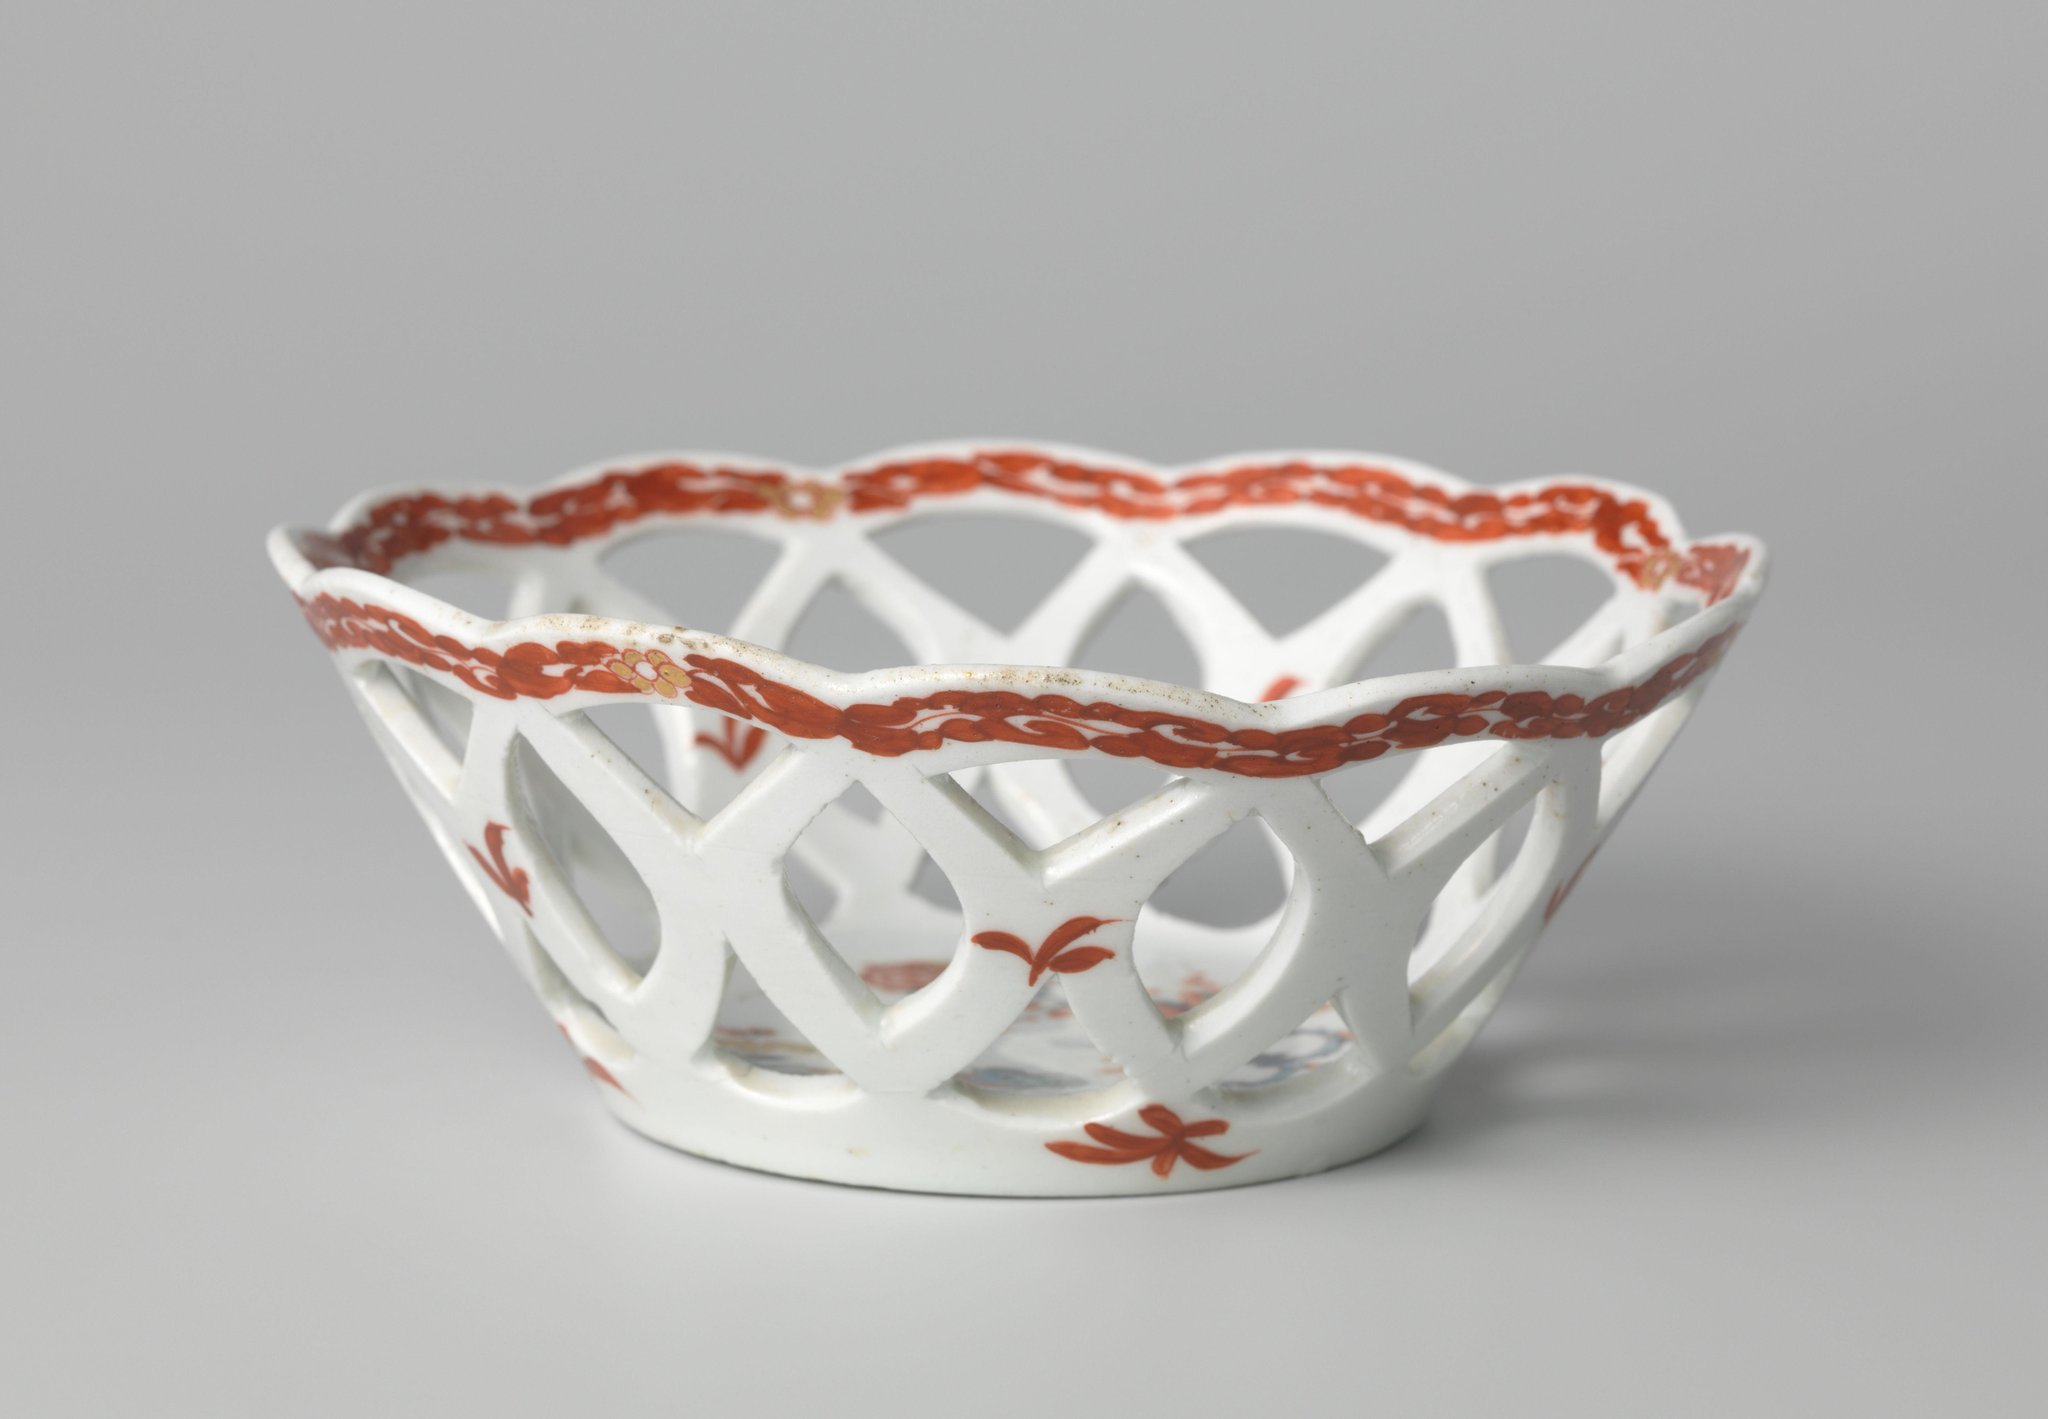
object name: bowl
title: Bowl with quails near flowering plants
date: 1750-1774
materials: glaze, gold, paint, porcelain, soft paste porcelain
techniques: embroidery, firing, forming, gilding, turning, vitrification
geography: worcester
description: Basket. Worcester, c. 1750 - 1775.